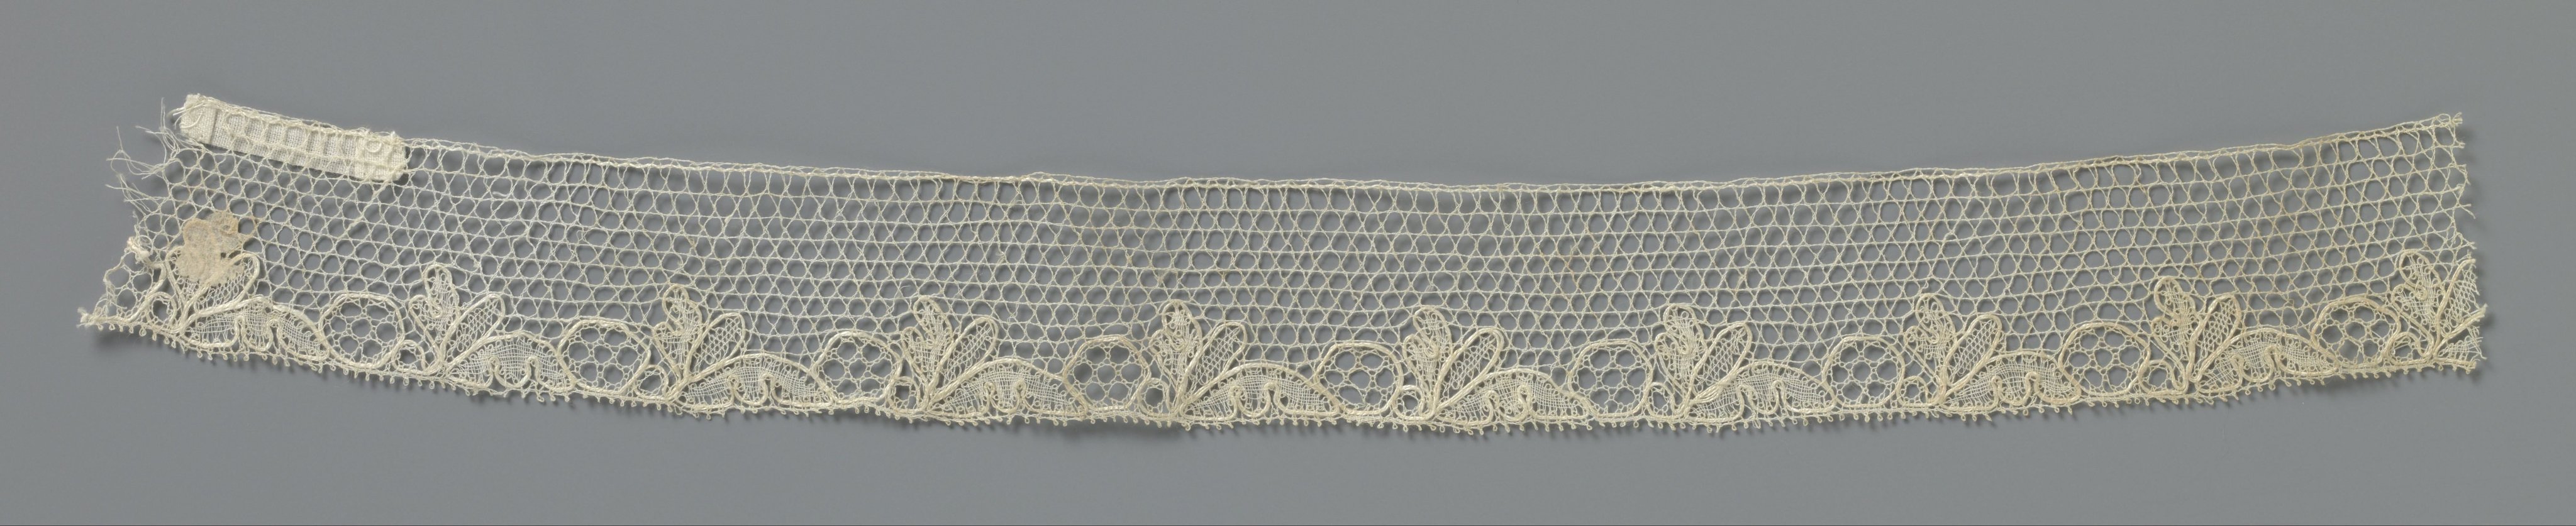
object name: strip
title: Strook kloskant met cirkeltjes en blaadjes langs de onderzijde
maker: Anonymous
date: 1850-1899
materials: linen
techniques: lace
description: Strook naturelkleurige kloskant, Parijse kant. Het patroon bestaat langs de onderzijde van de strook uit een aaneenschakeling van een groot en een klein cirkeltje en twee verschillende blaadjes. De motieven zijn met elkaar verbonden door een maasgrond, een Parijse grond. De motieven zijn gemaakt in losgewerkte linnenslag en netslag, met dikkere en glimmende contourdraden. In de cirkeltjes is als siergrond een rozengrond toegepast. Boven en onderzijde zijn recht afgewerkt, waarbij de onderzijde is voorzien van picots.